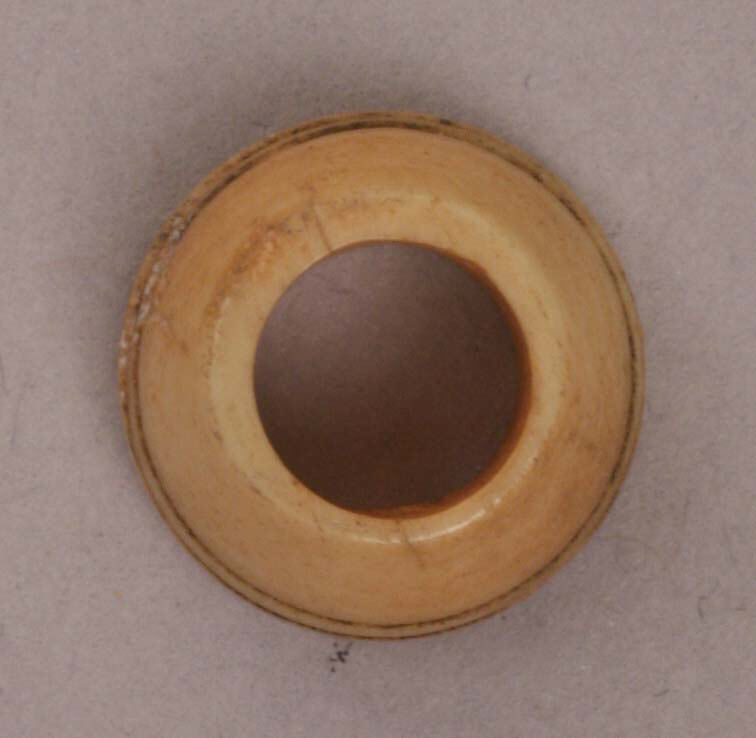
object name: button or bead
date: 801-1000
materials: bone, paint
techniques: incising, inlay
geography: iran